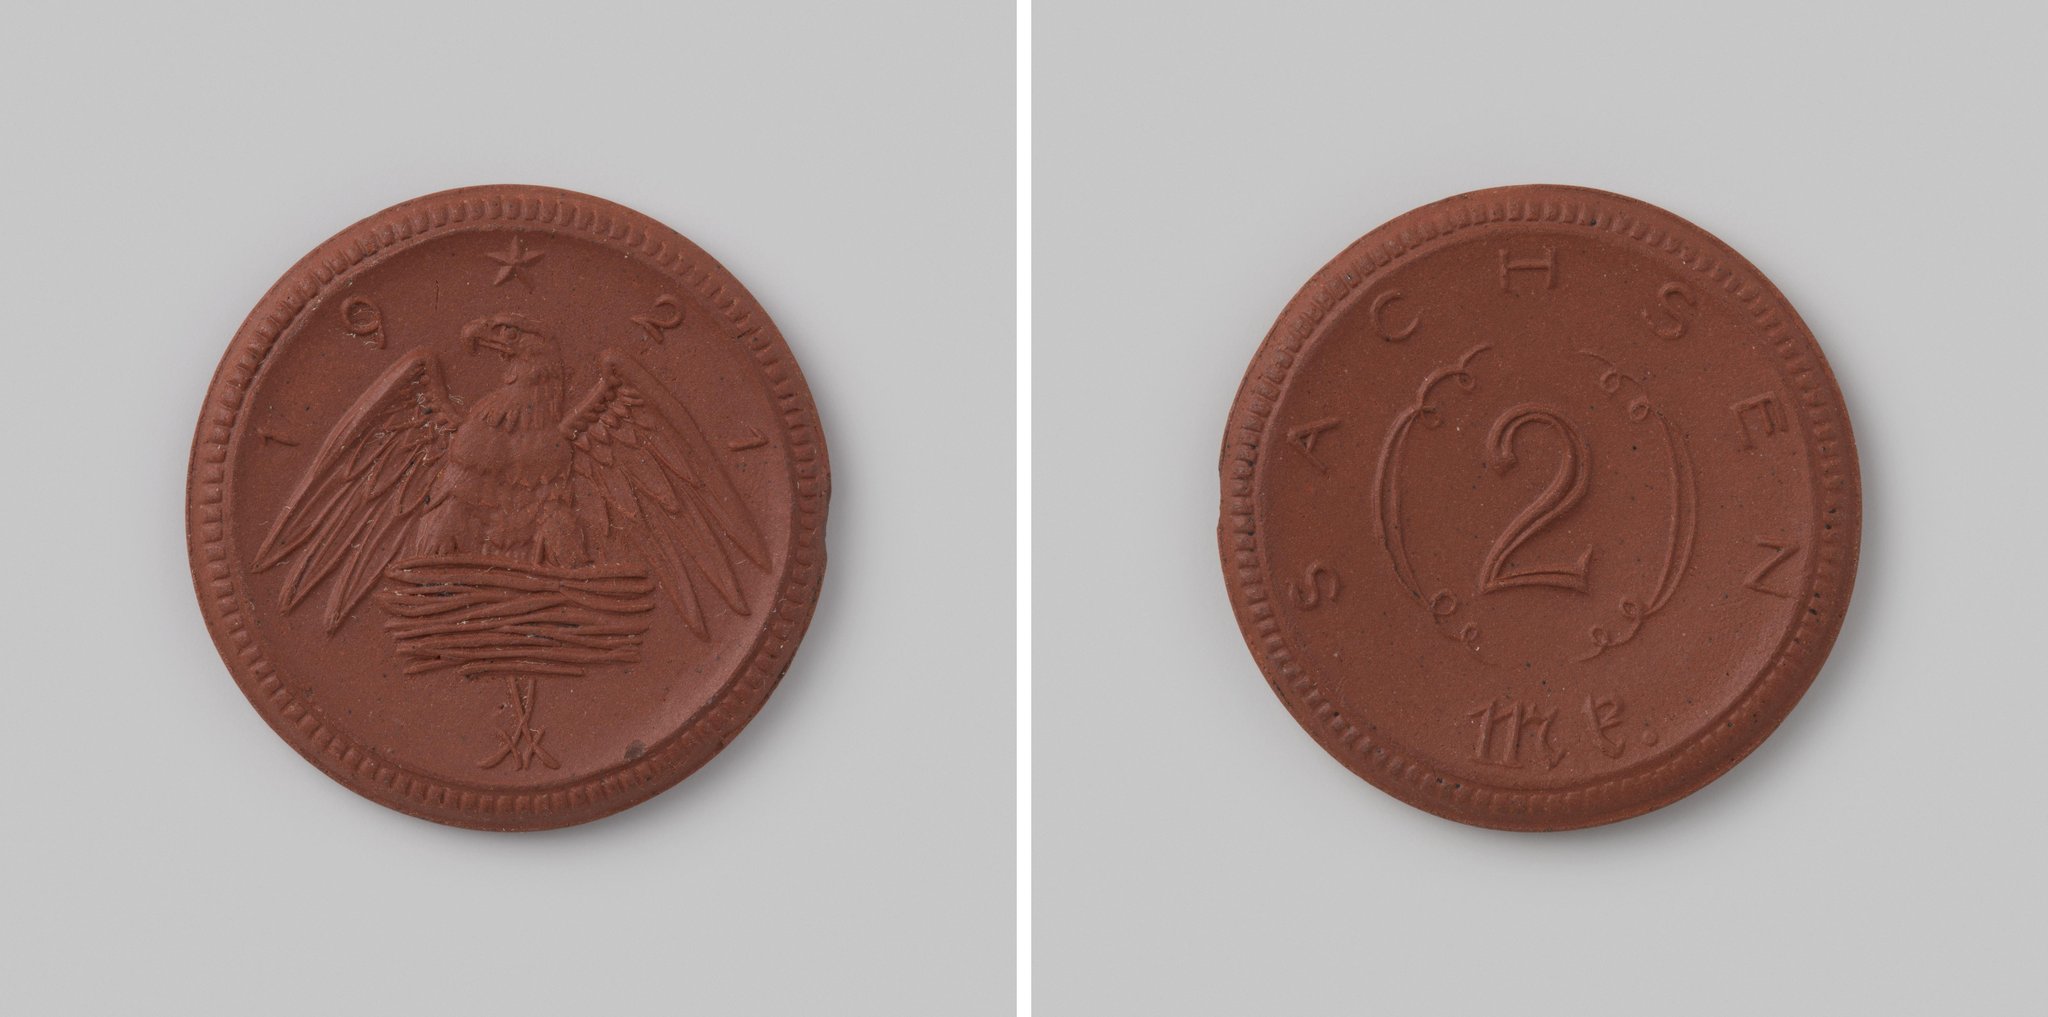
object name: coin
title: Duitsland, Saksen, 2 mark, 1921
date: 1921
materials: porcelain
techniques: casting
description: Porseleinen pseudomunt. Voorzijde: adelaar op nest, waarboven jaartal. Keerzijde: binnen versiering waarde-aanduiding in twee regels. Daaromheen land-aanduiding. Gladde rand.